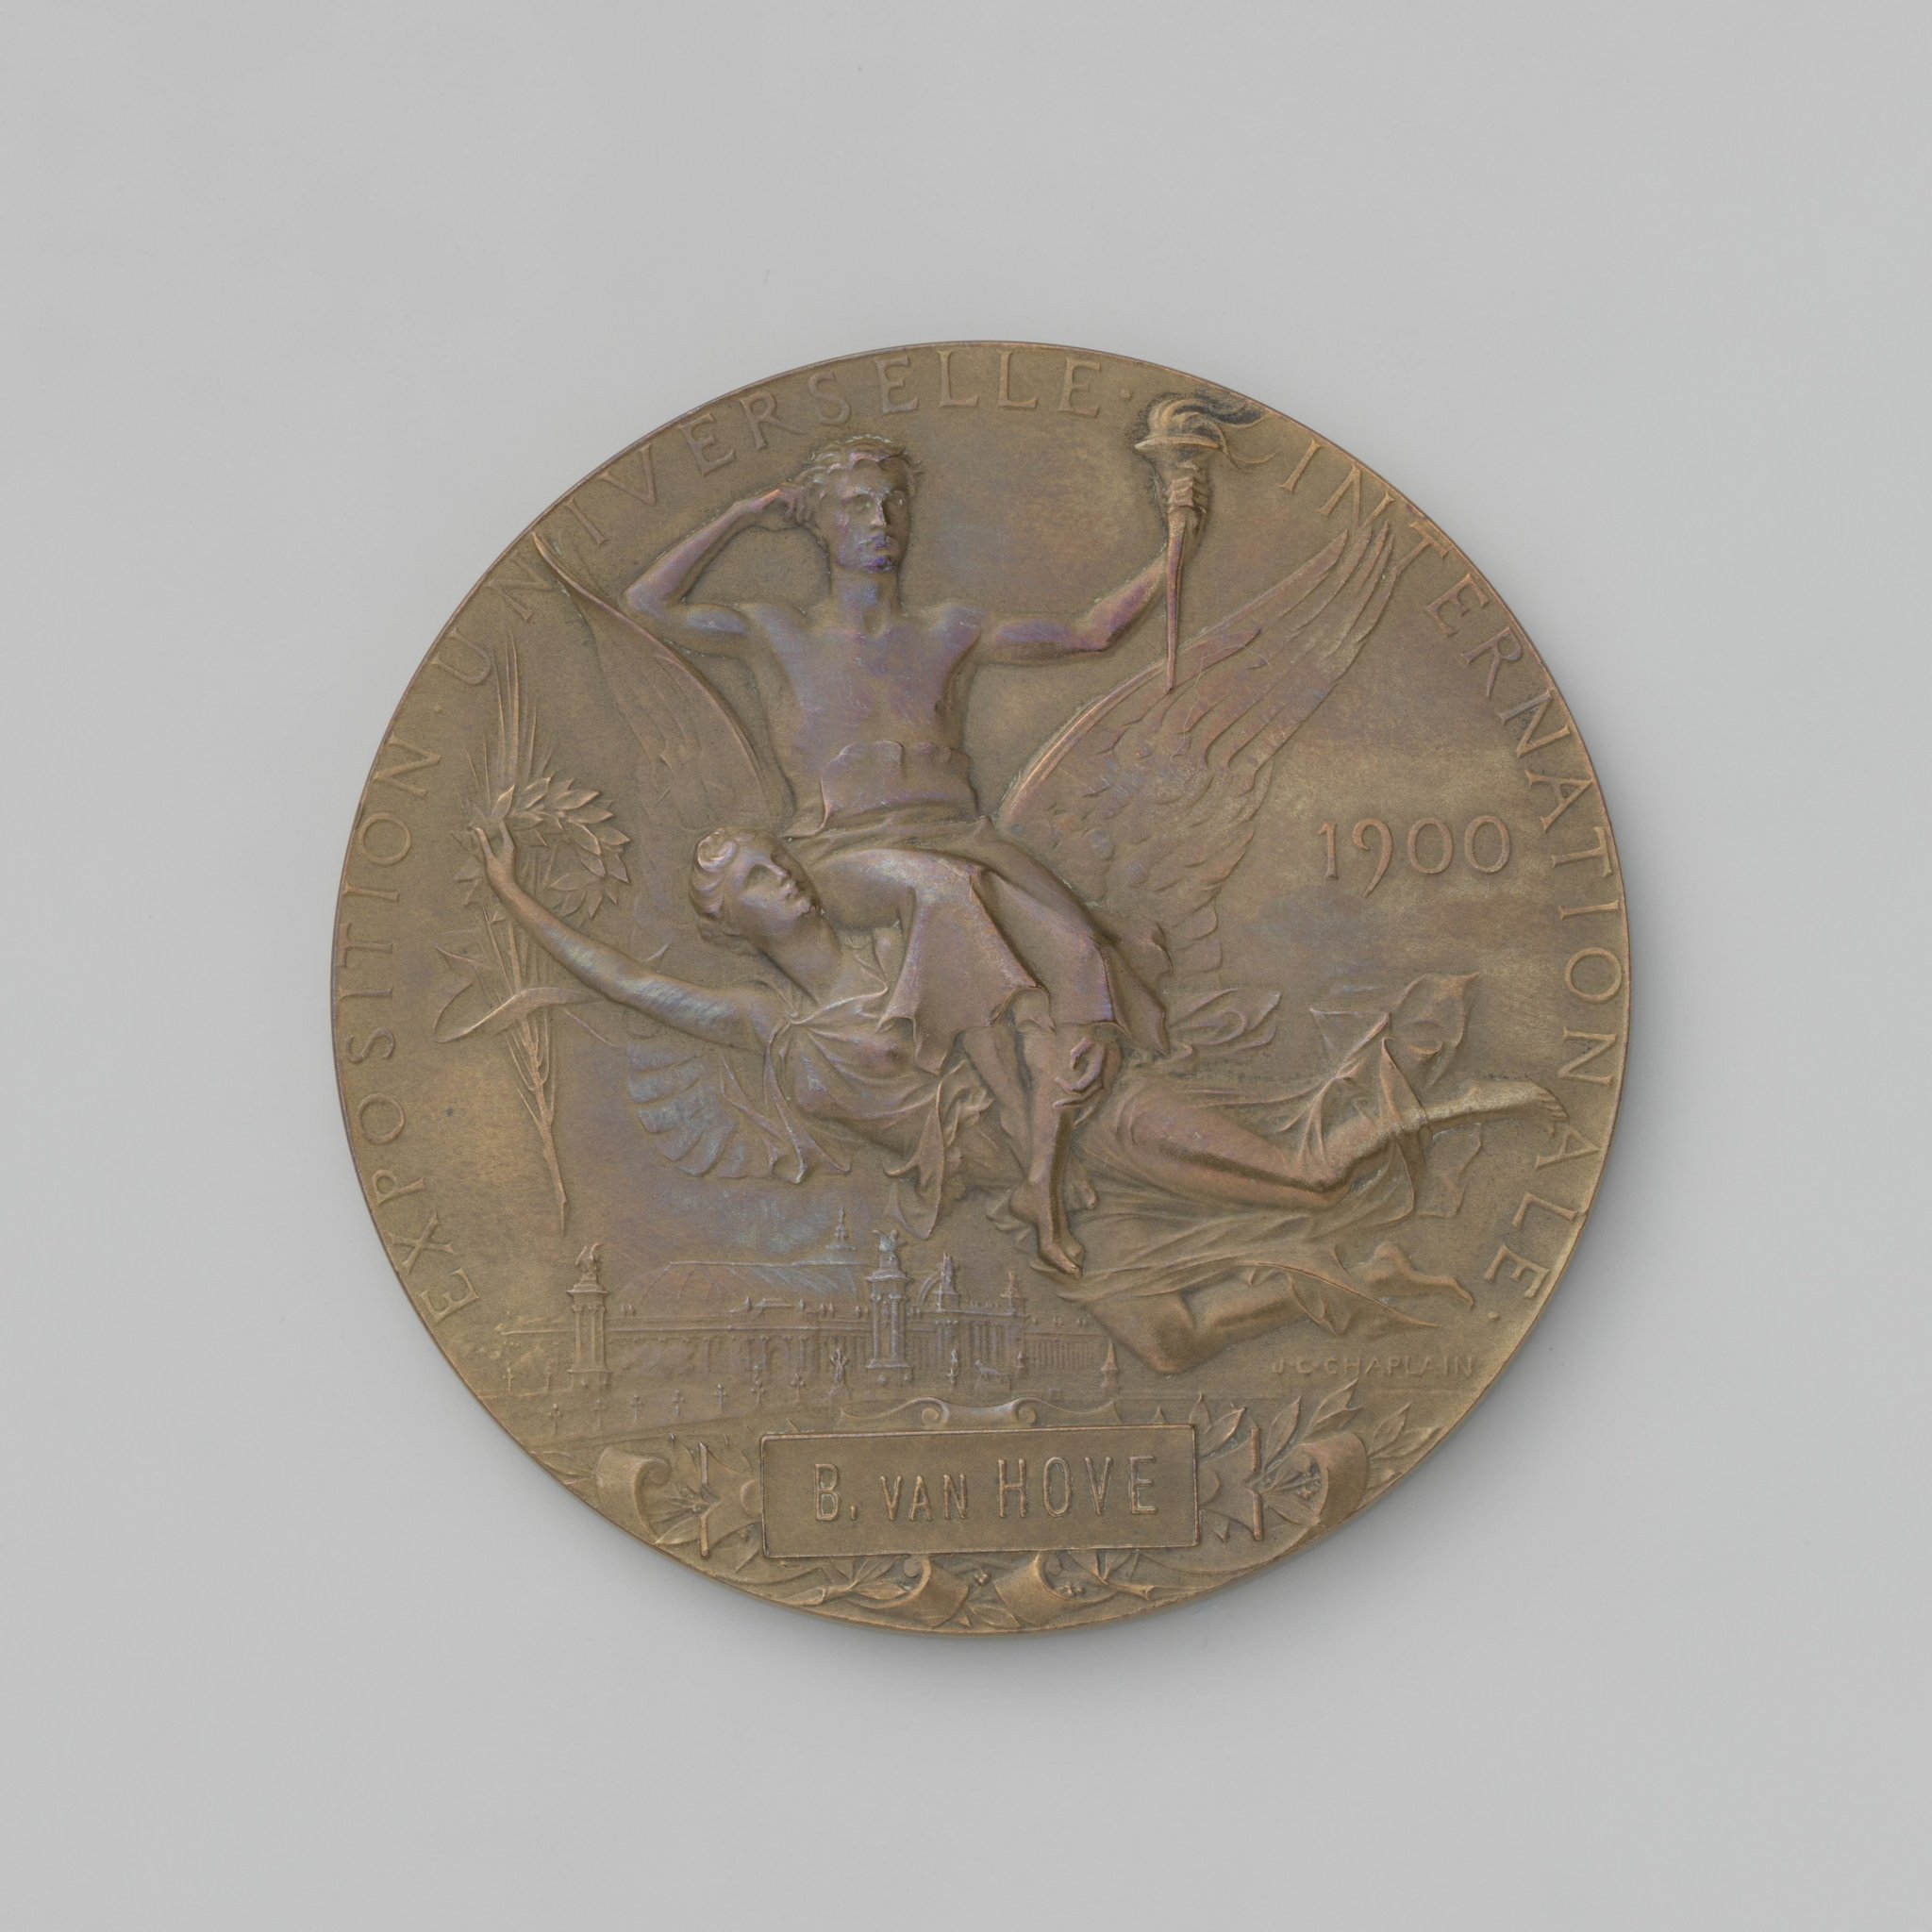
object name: medal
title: Prize Medal Awarded to Bart van Hove at the Exposition Universelle in Paris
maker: jules clement chaplain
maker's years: 1839-1909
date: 1900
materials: bronze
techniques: striking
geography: france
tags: the hague, amsterdam, sculptor, bart van hove, paris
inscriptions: circumscription: ‘REPUBLIQUE FRANÇAISE’, inscription: ‘B. VAN HOVE’, circumscription: ‘EXPOSITION UNIVERSELLE INTERNATIONALE 1900’, signature: ‘J.C. CHAPLAIN’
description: Medals of honour. Medals of honour were awarded to individuals for noteworthy achievements.